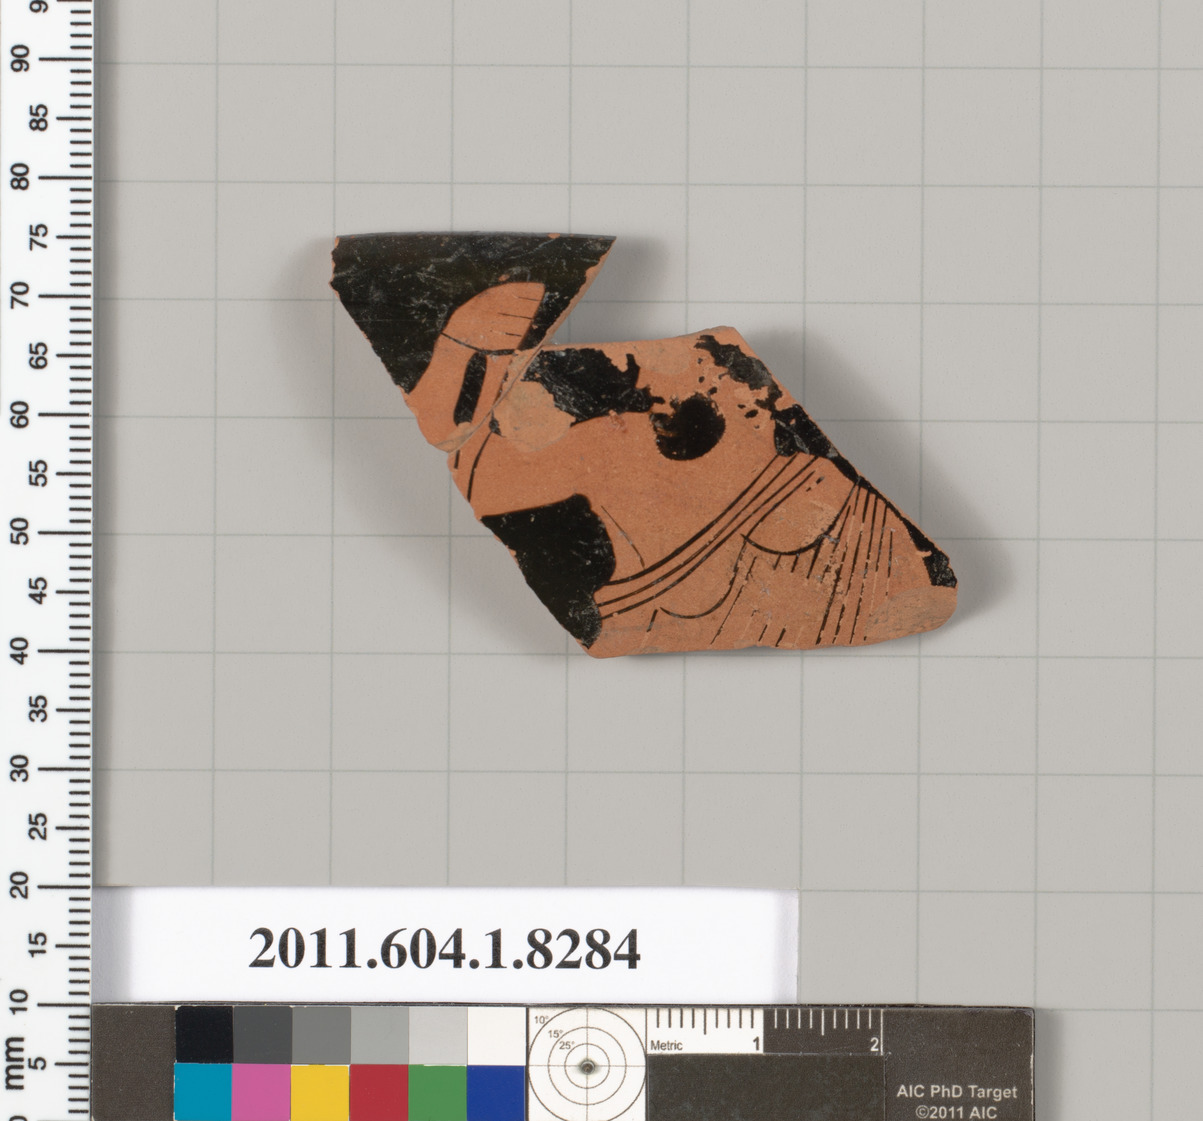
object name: kylix fragment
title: Terracotta rim fragment of a kylix (drinking cup)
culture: greek, attic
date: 400-351 BCE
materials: terracotta